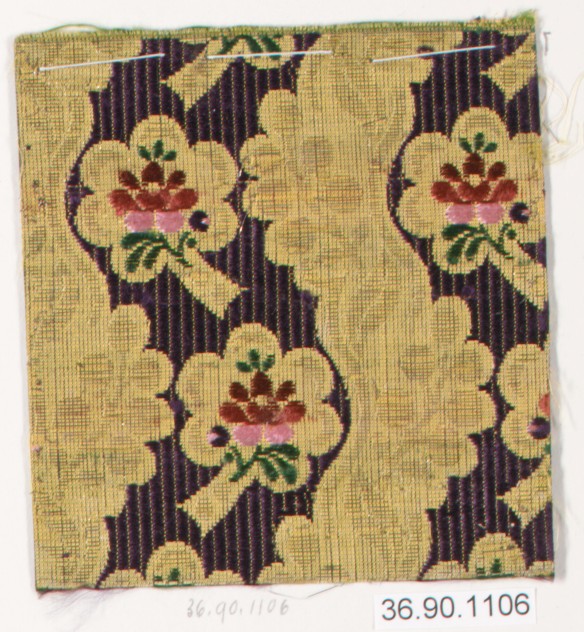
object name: sample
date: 1701-1900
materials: metal thread, silk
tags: flowers